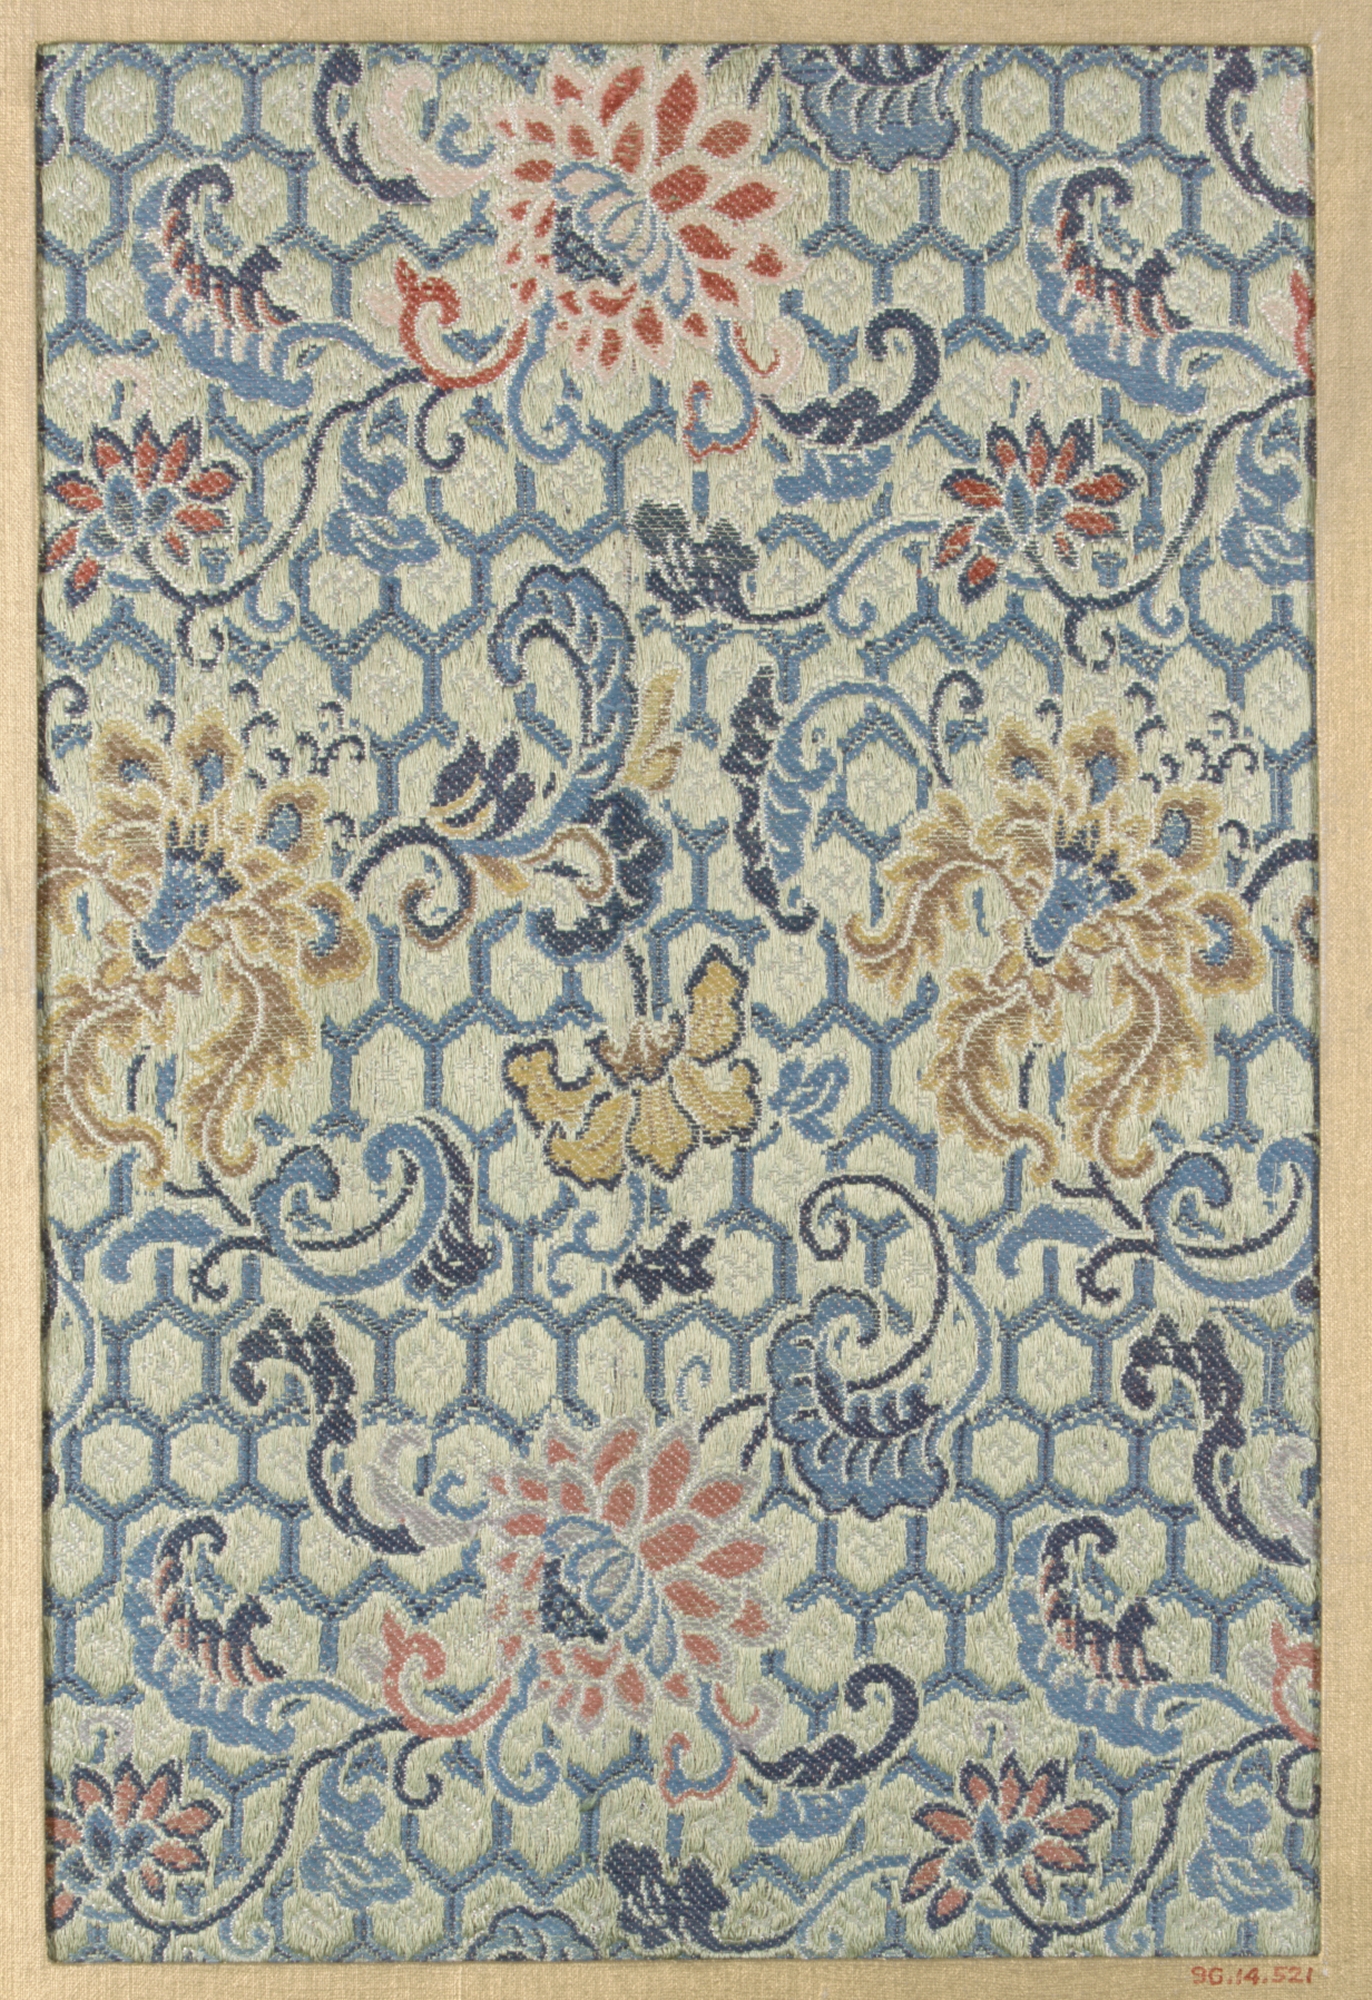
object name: piece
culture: japanese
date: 1701-1900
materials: silk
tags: flowers